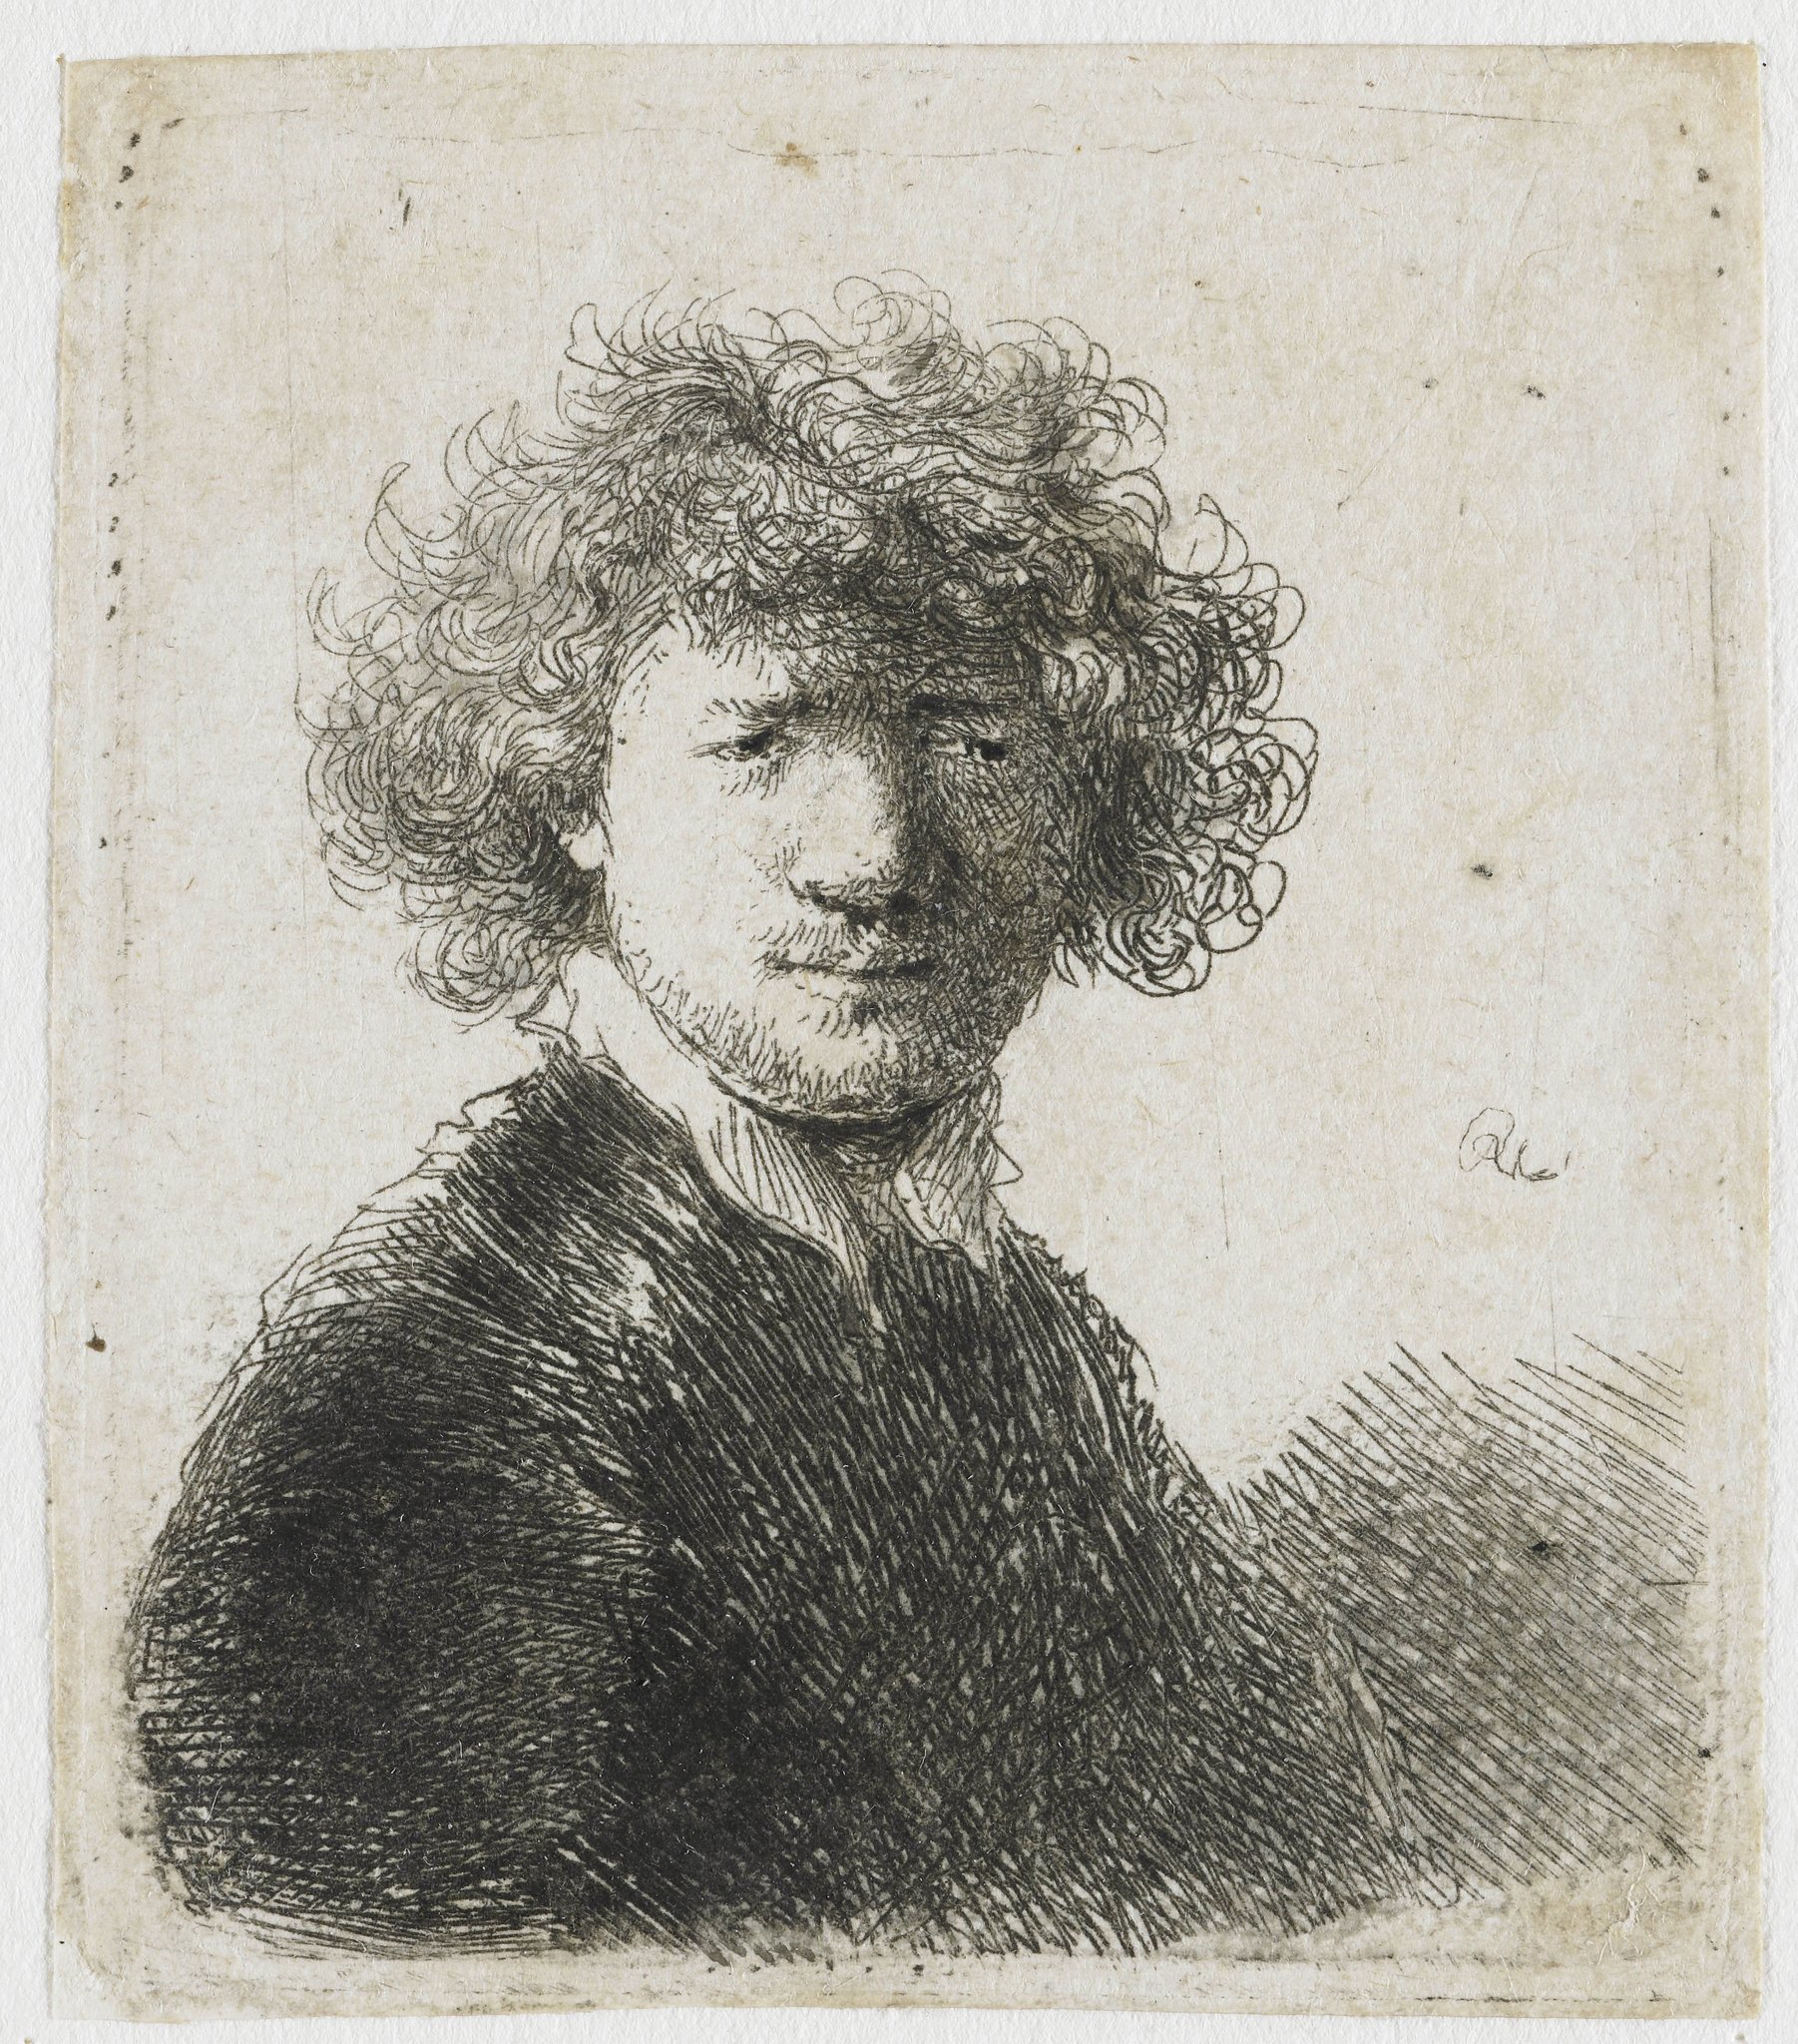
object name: print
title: Self-portrait with curly hair and white collar: bust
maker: rembrandt van rijn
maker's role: draughtsman, painter, print maker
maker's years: 1606-1669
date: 1630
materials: paper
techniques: etching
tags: leiden, amsterdam, painter, print maker, rembrandt van rijn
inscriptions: monogram: ‘RHL’, mark: Lugt 2228